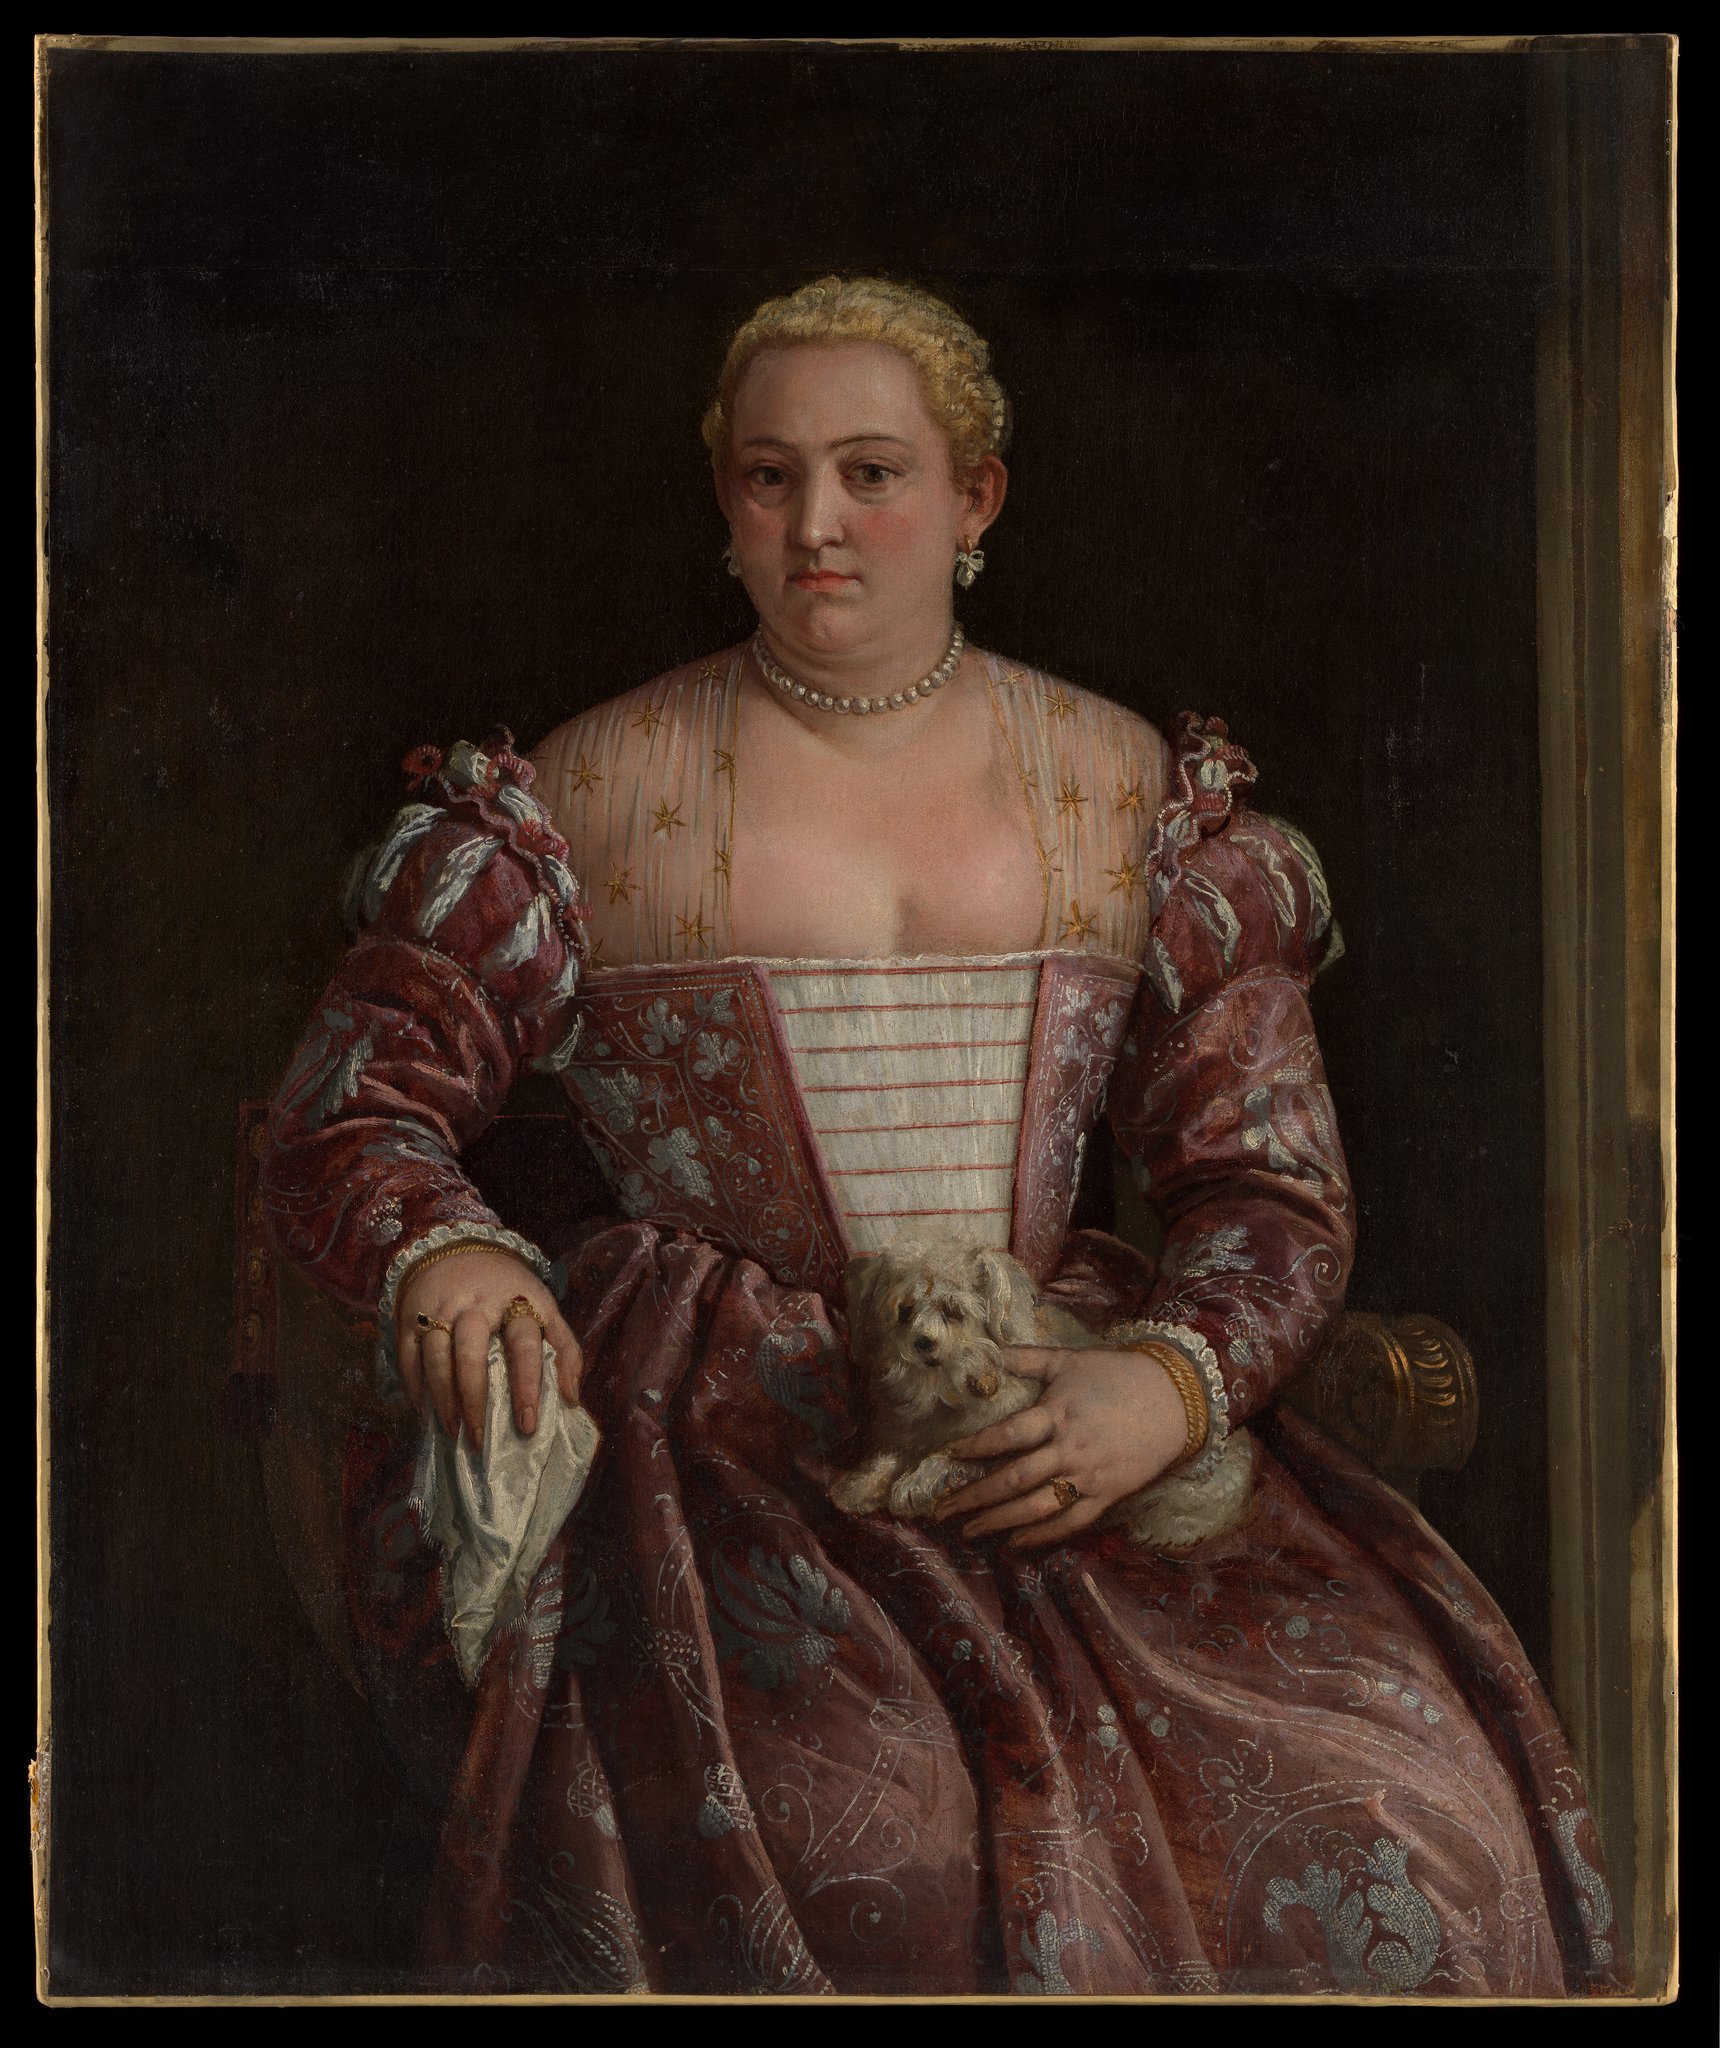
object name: painting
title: Portrait of a Woman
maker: francesco montemezzano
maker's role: artist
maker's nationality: italian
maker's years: 1540-1602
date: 1560-1602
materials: canvas, oil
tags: portraits,women,dogs